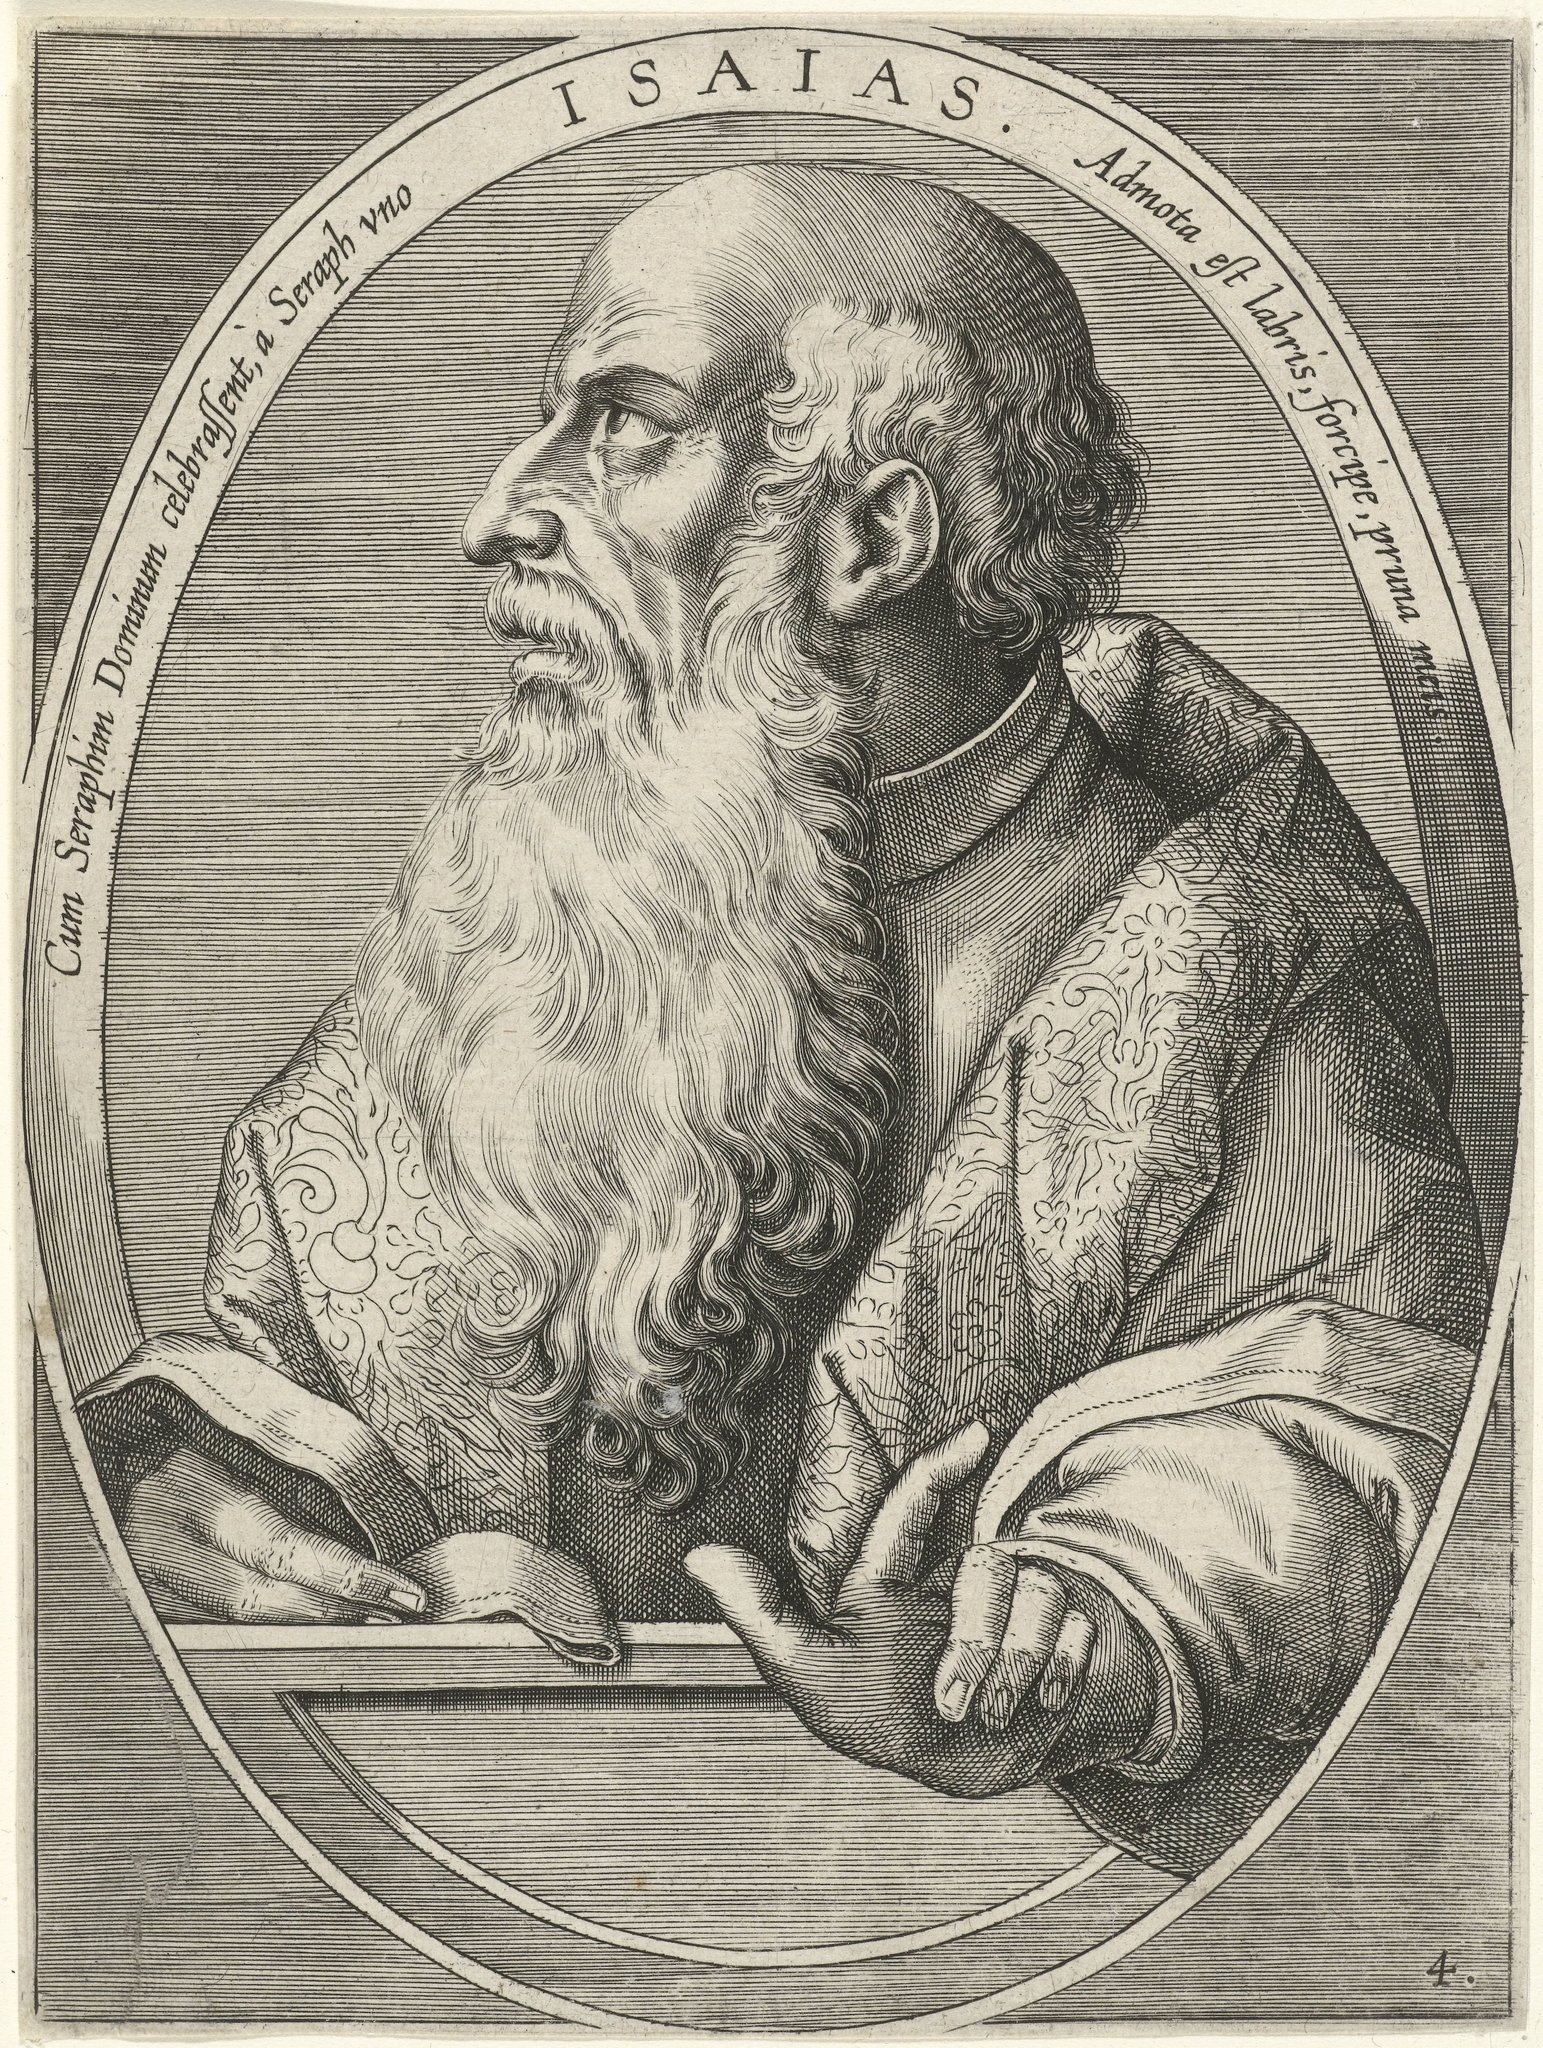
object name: print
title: Icones Prophetarum Veteris Testamenti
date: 1613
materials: paper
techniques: engraving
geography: antwerp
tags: isaiah (not in biblical context); possible attributes: branch with leaves, saw, scroll or book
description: De profeet Jesaja met een boek in de hand, in ovaal met Latijns randschrift. Met zijn hand maakt hij een spreekgebaar.